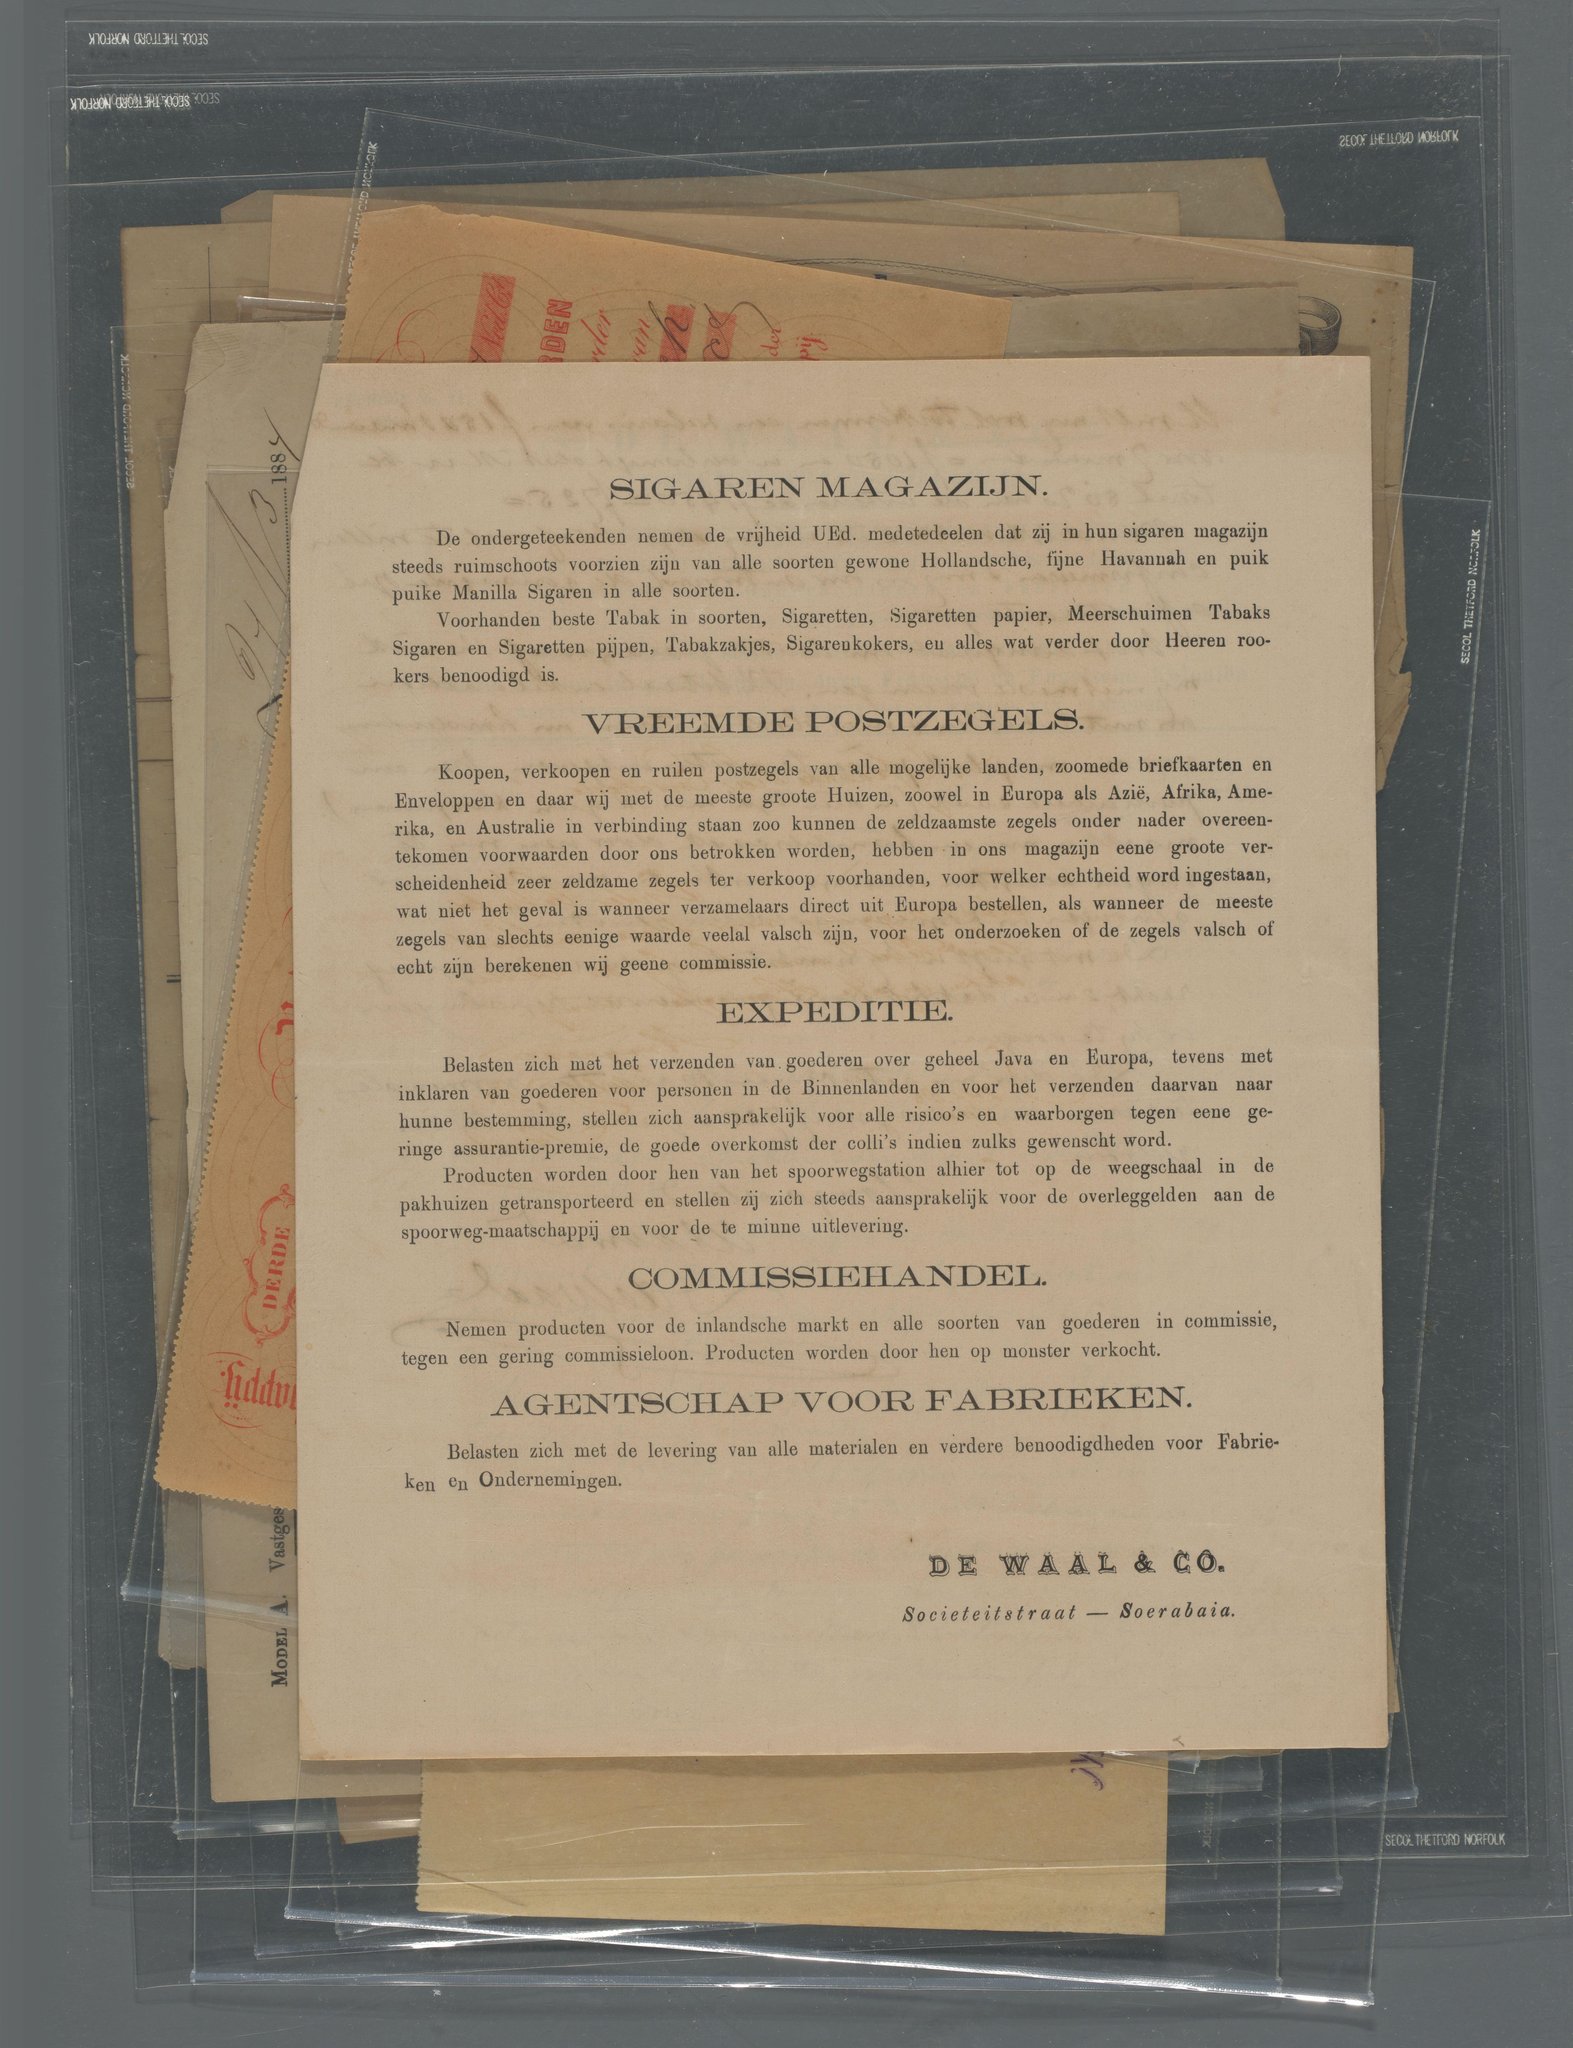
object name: document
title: Map met 12 wissels en rekeningen afkomstig uit Nederlands-Indië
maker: Anonymous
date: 1860-1886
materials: paper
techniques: printing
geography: indonesia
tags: dutch east indies, the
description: Map met 12 documenten van verschillend formaat.